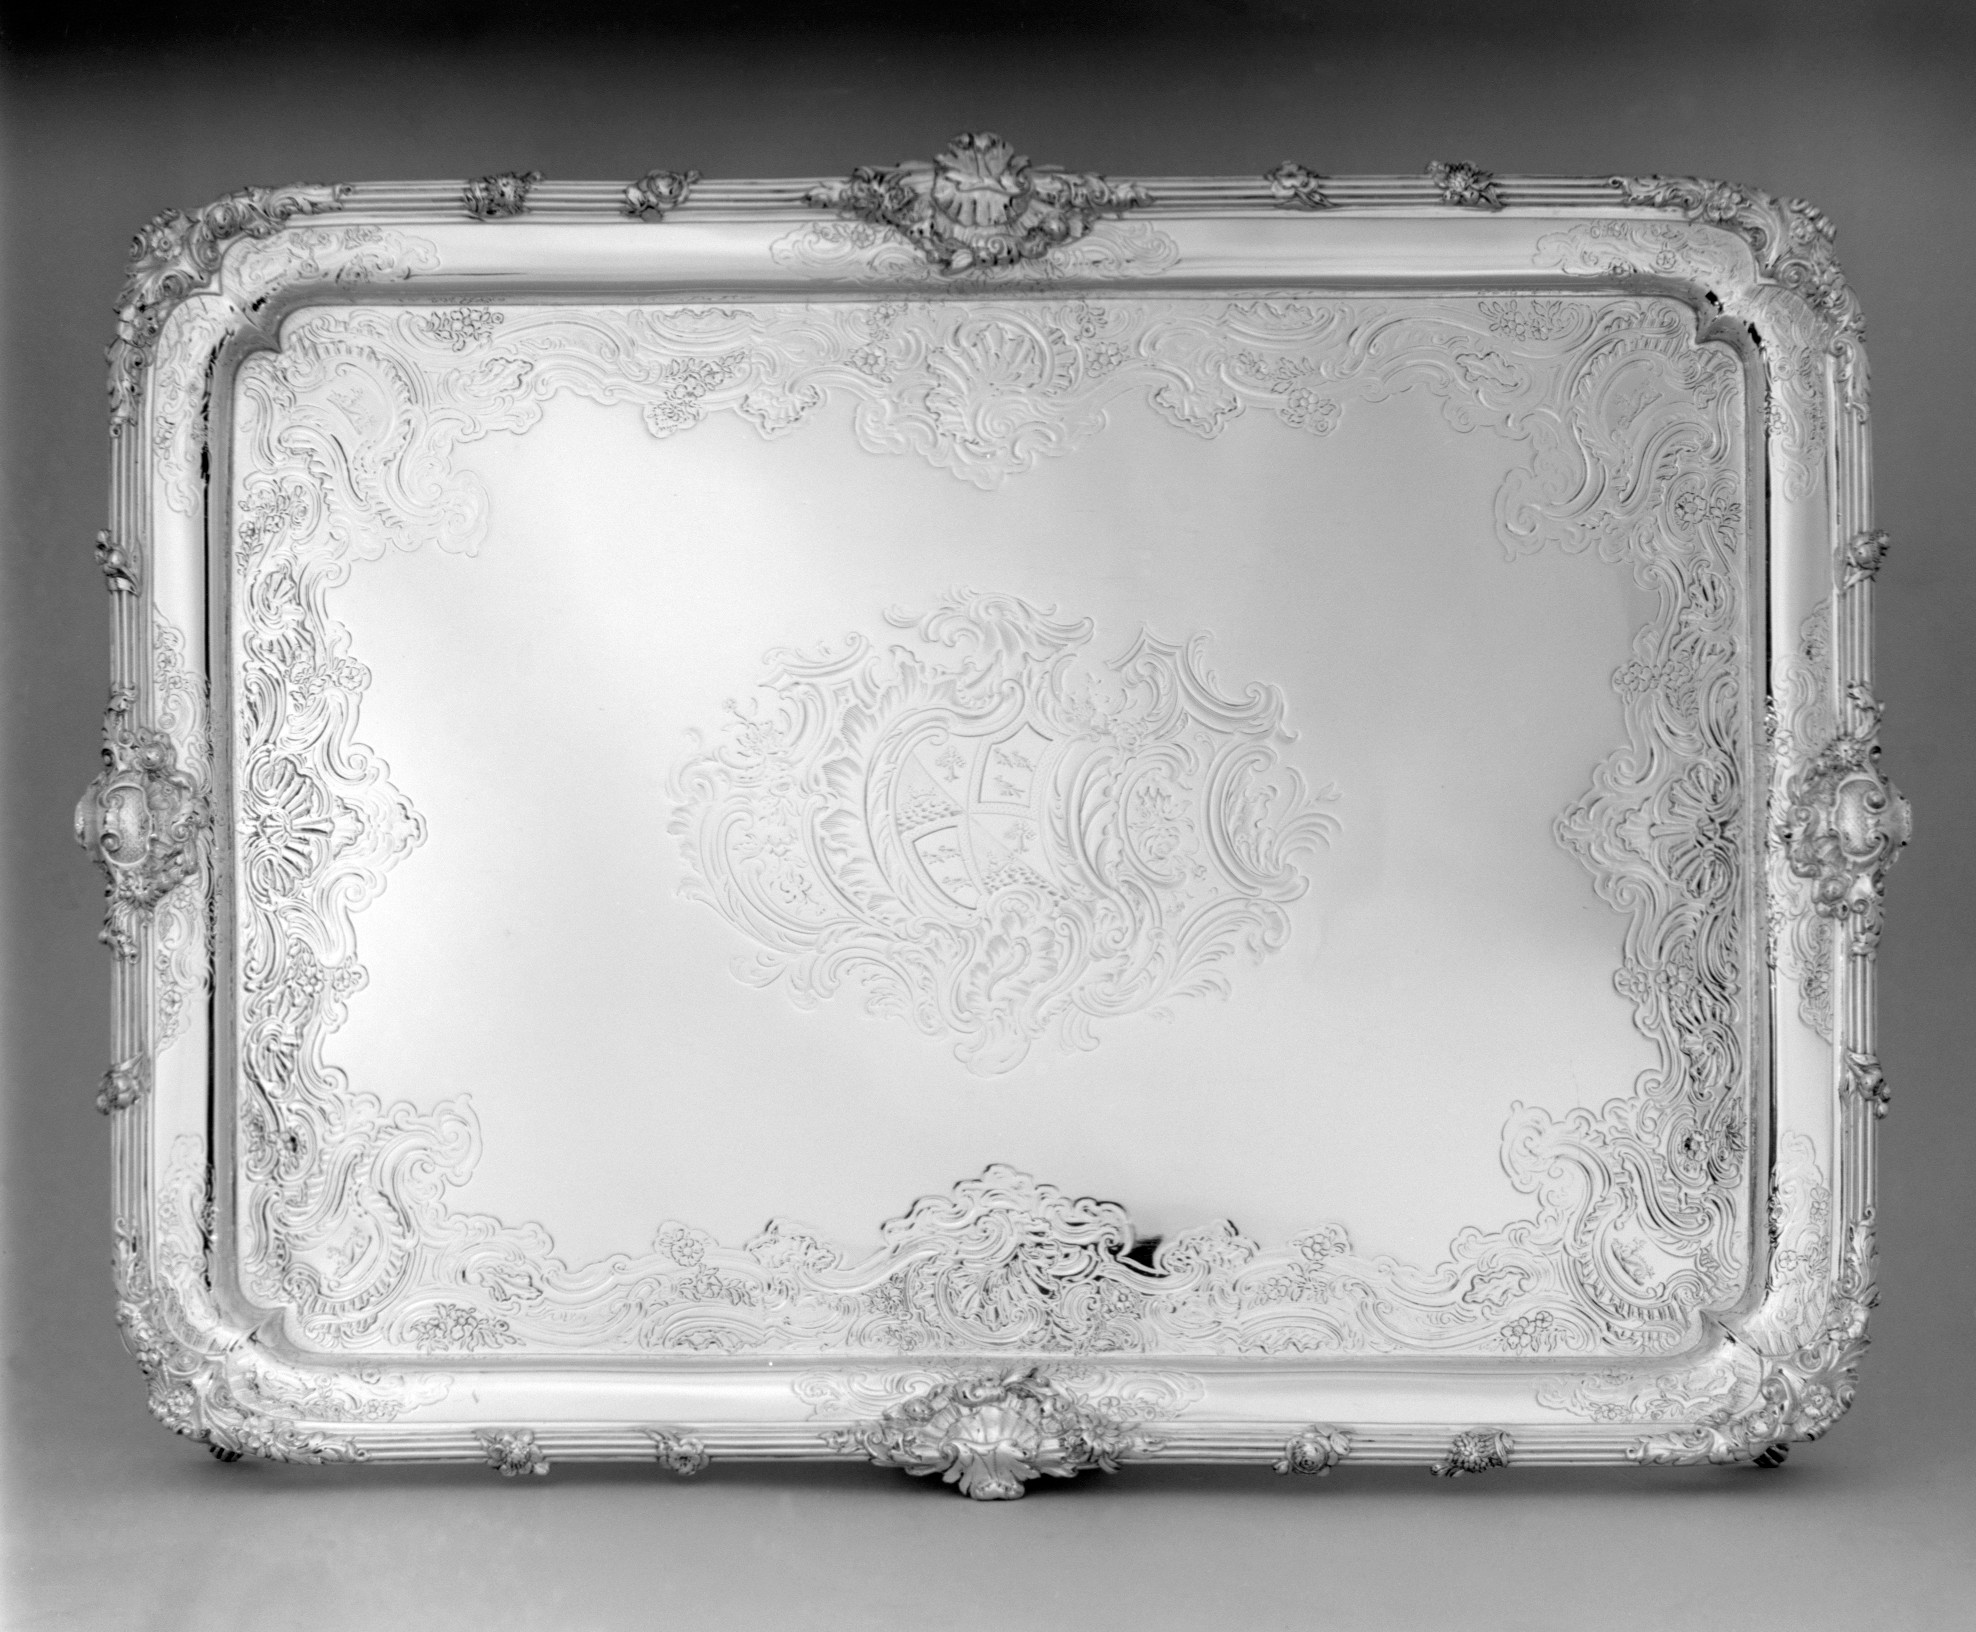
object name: tray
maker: paul de lamerie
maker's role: maker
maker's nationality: british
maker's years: 1688-1751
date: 1741-1742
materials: silver